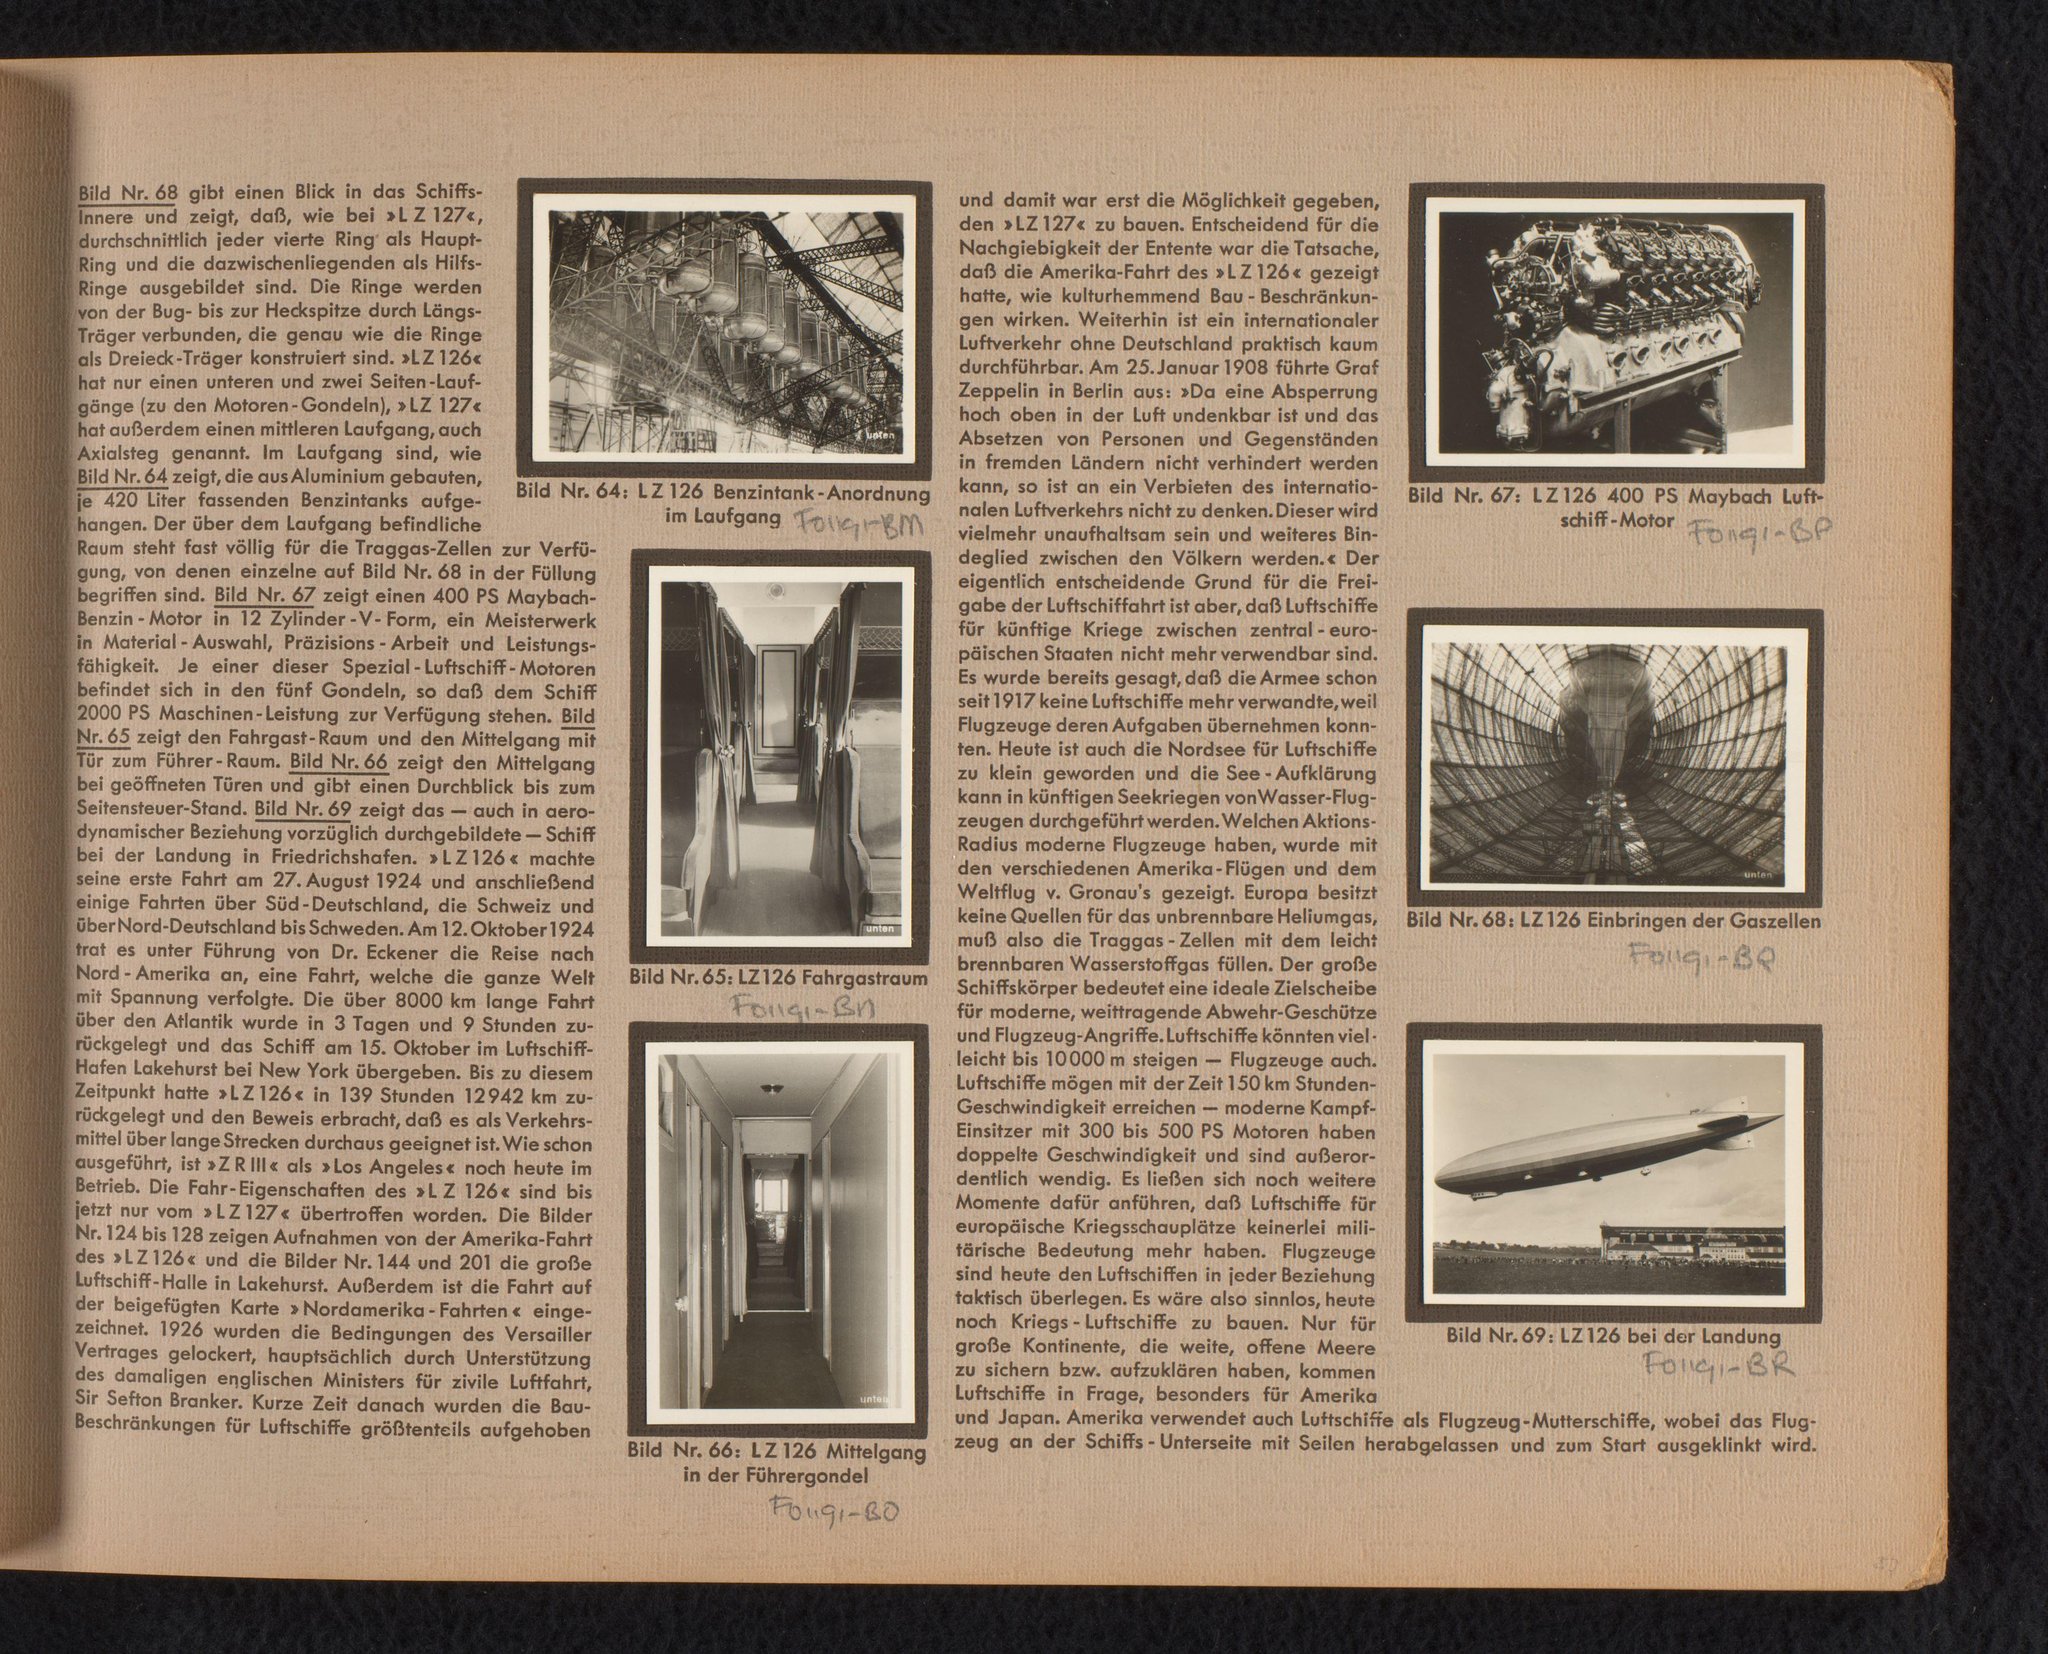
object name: album leaf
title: Verschillende onderdelen van een zeppelin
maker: Anonymous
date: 1919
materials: paper, photographic support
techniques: gelatin silver print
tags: 46c35 airship, zeppelin, airship, zeppelin (+ arrival, coming to anchor, at anchor), historical persons, germany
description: Zes foto's van onder meer verschillende onderdelen van LZ126 en een gezicht op de landing van LZ126. Alle foto's zijn voorzien van een nummer en titel. Deze pagina maakt deel uit van een album.